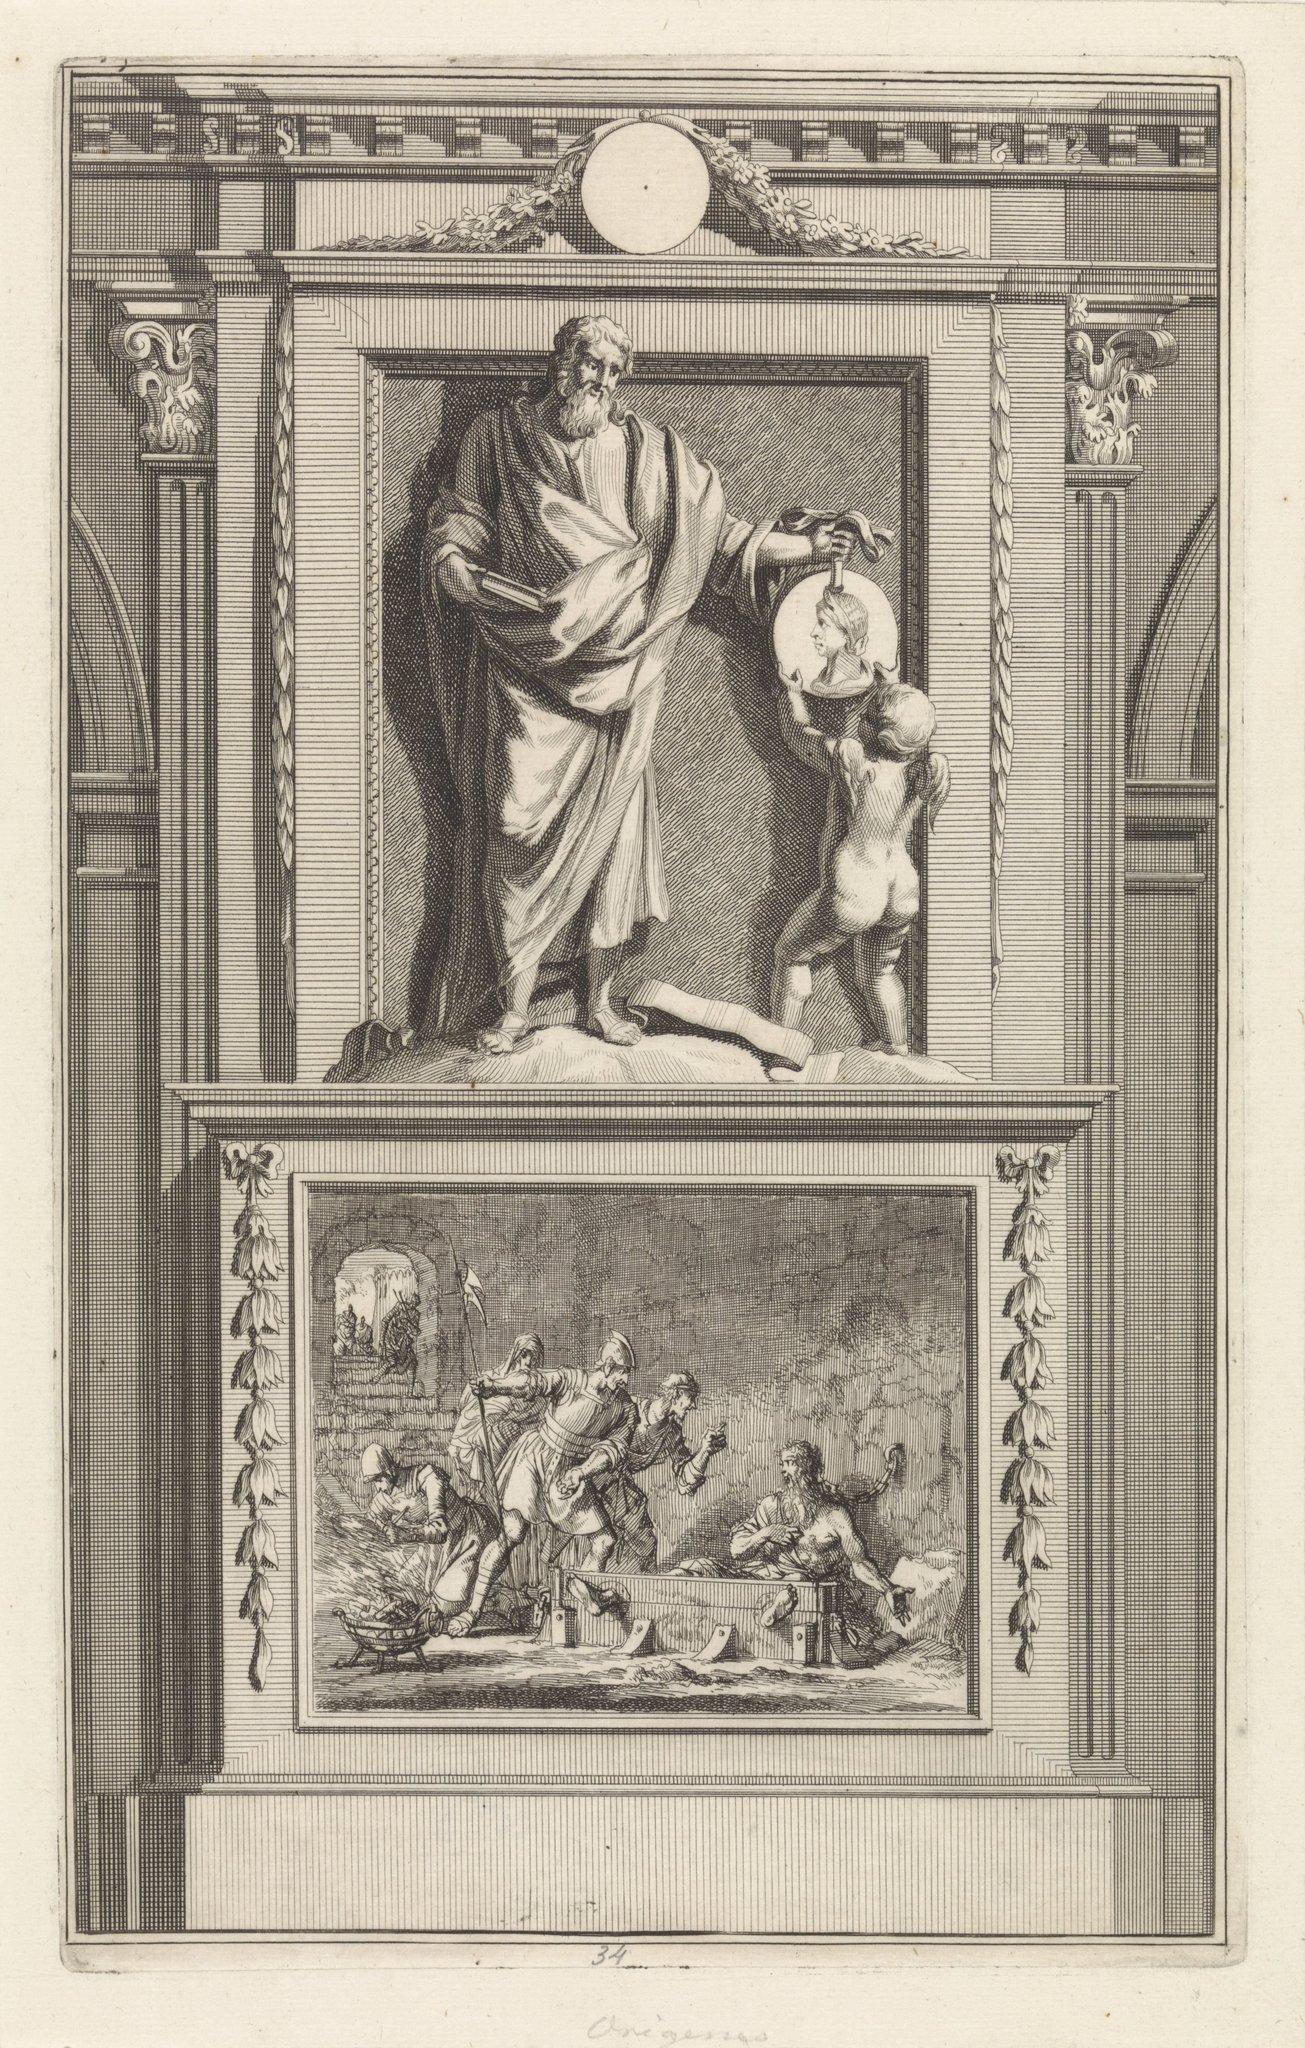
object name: print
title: Kerkvader Origenes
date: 1698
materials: paper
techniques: engraving, etching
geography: amsterdam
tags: prison, jail, instruments of torture, execution or punishment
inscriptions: collector's mark: Lugt 2228, number: ‘34’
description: Proefdruk van illustratie uit: Cave, William. Apostolische oudheden, of Het leven (...) der heylige apostelen, 3 delen. Utrecht: François Halma en Willem van de Water (I), 1698, p. 254.